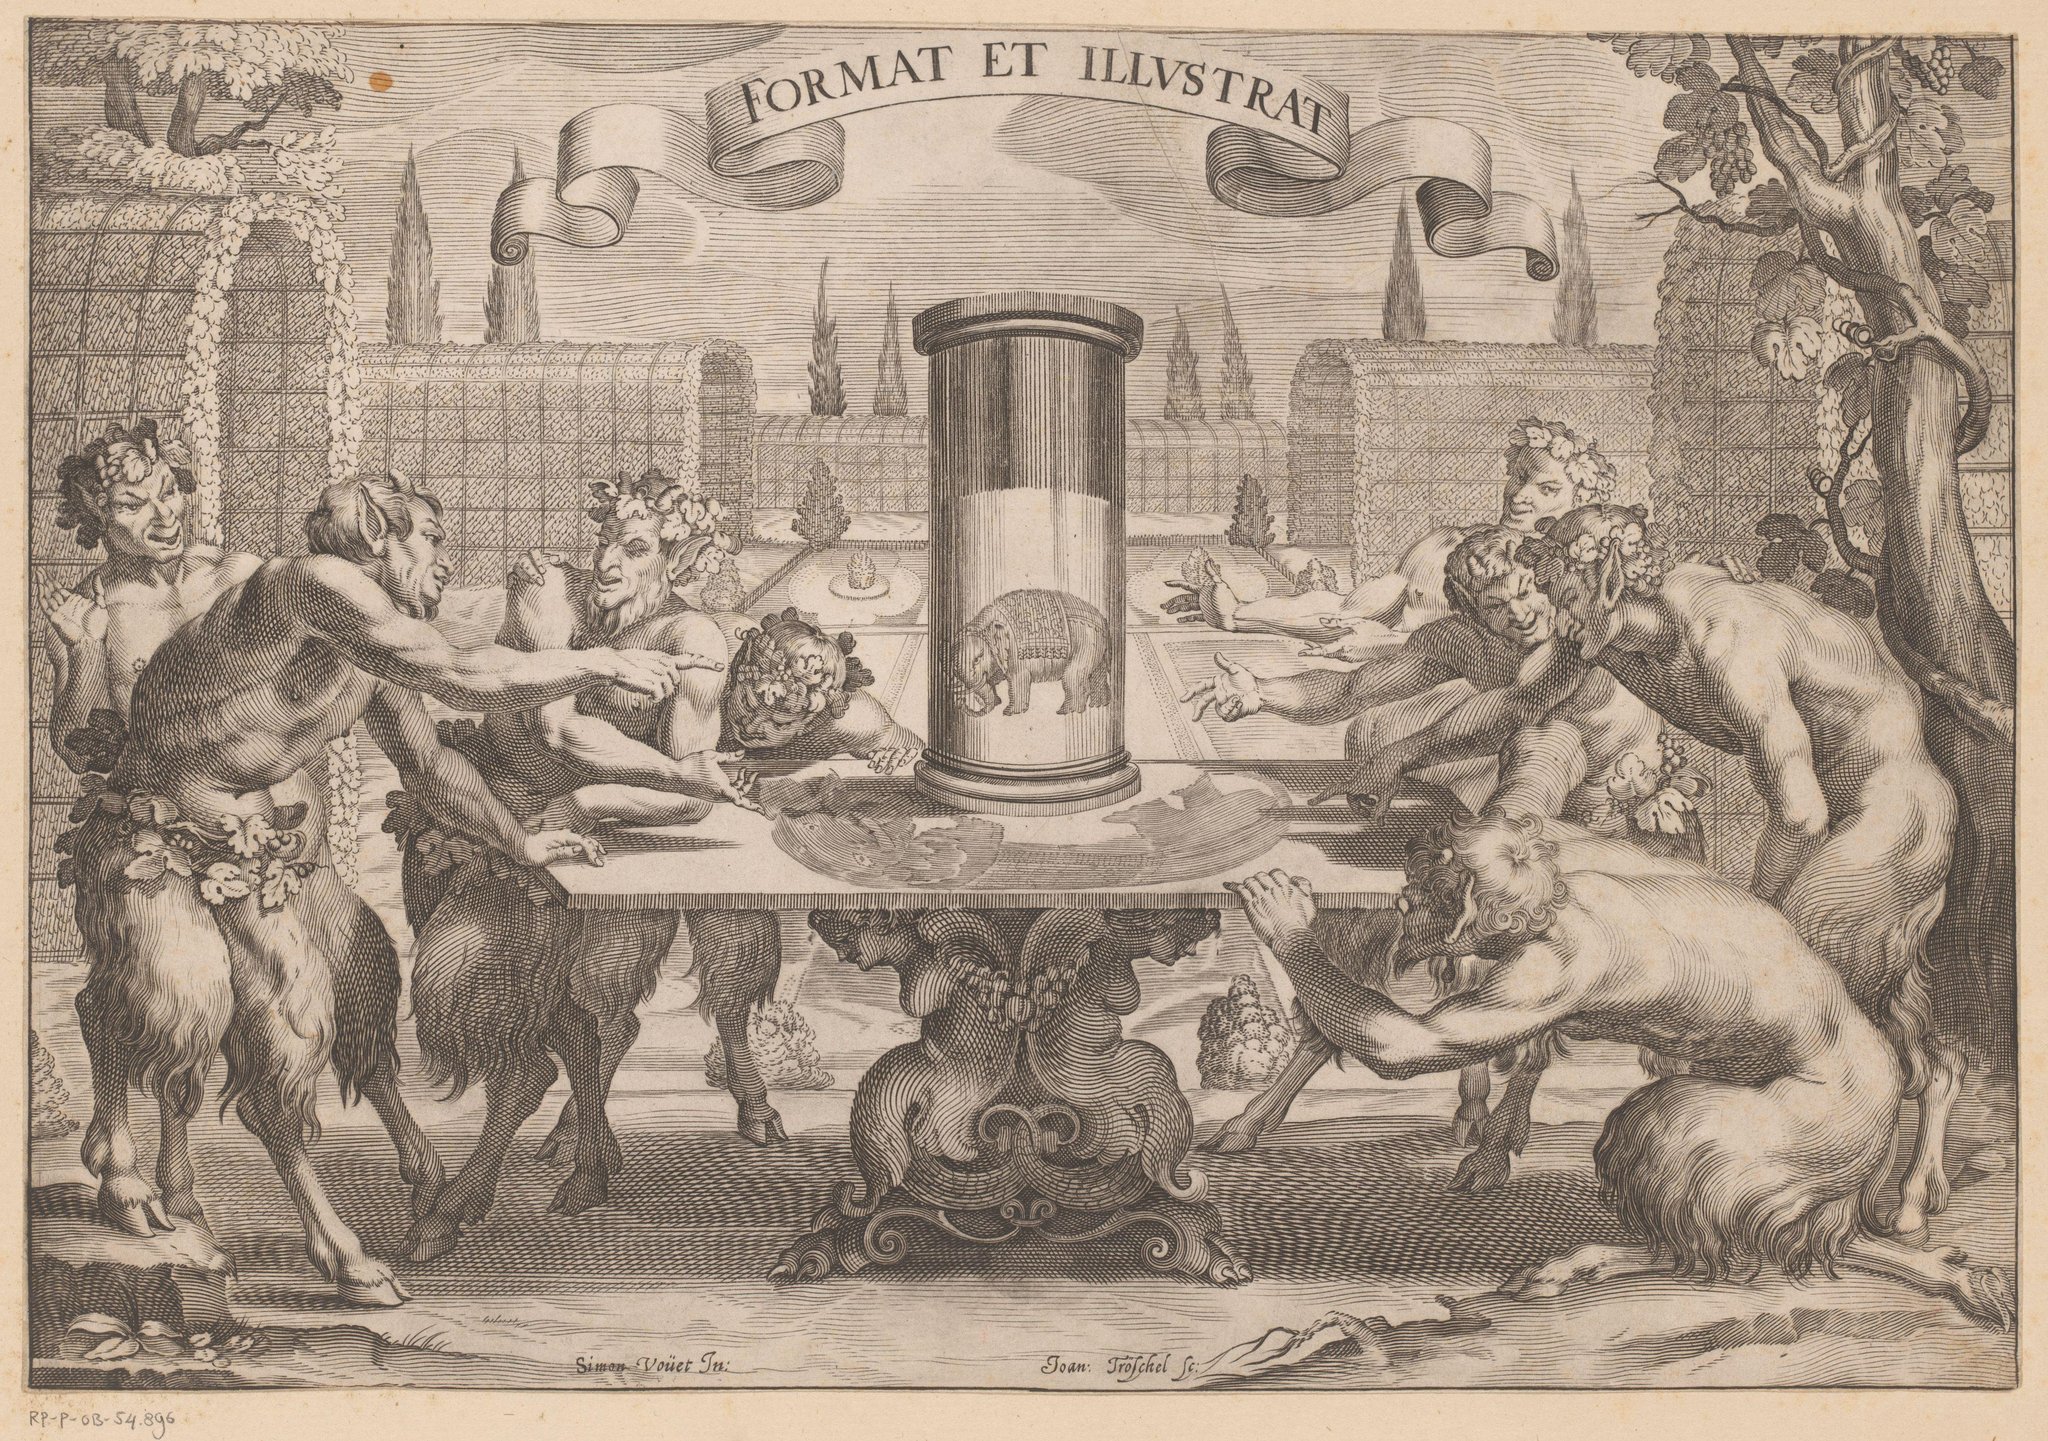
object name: print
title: Format et Illustrat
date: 1600-1628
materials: paper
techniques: engraving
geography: germany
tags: anamorphosis, satyr(s) (in general), trunked animals: elephant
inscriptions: collector's mark: Lugt 240